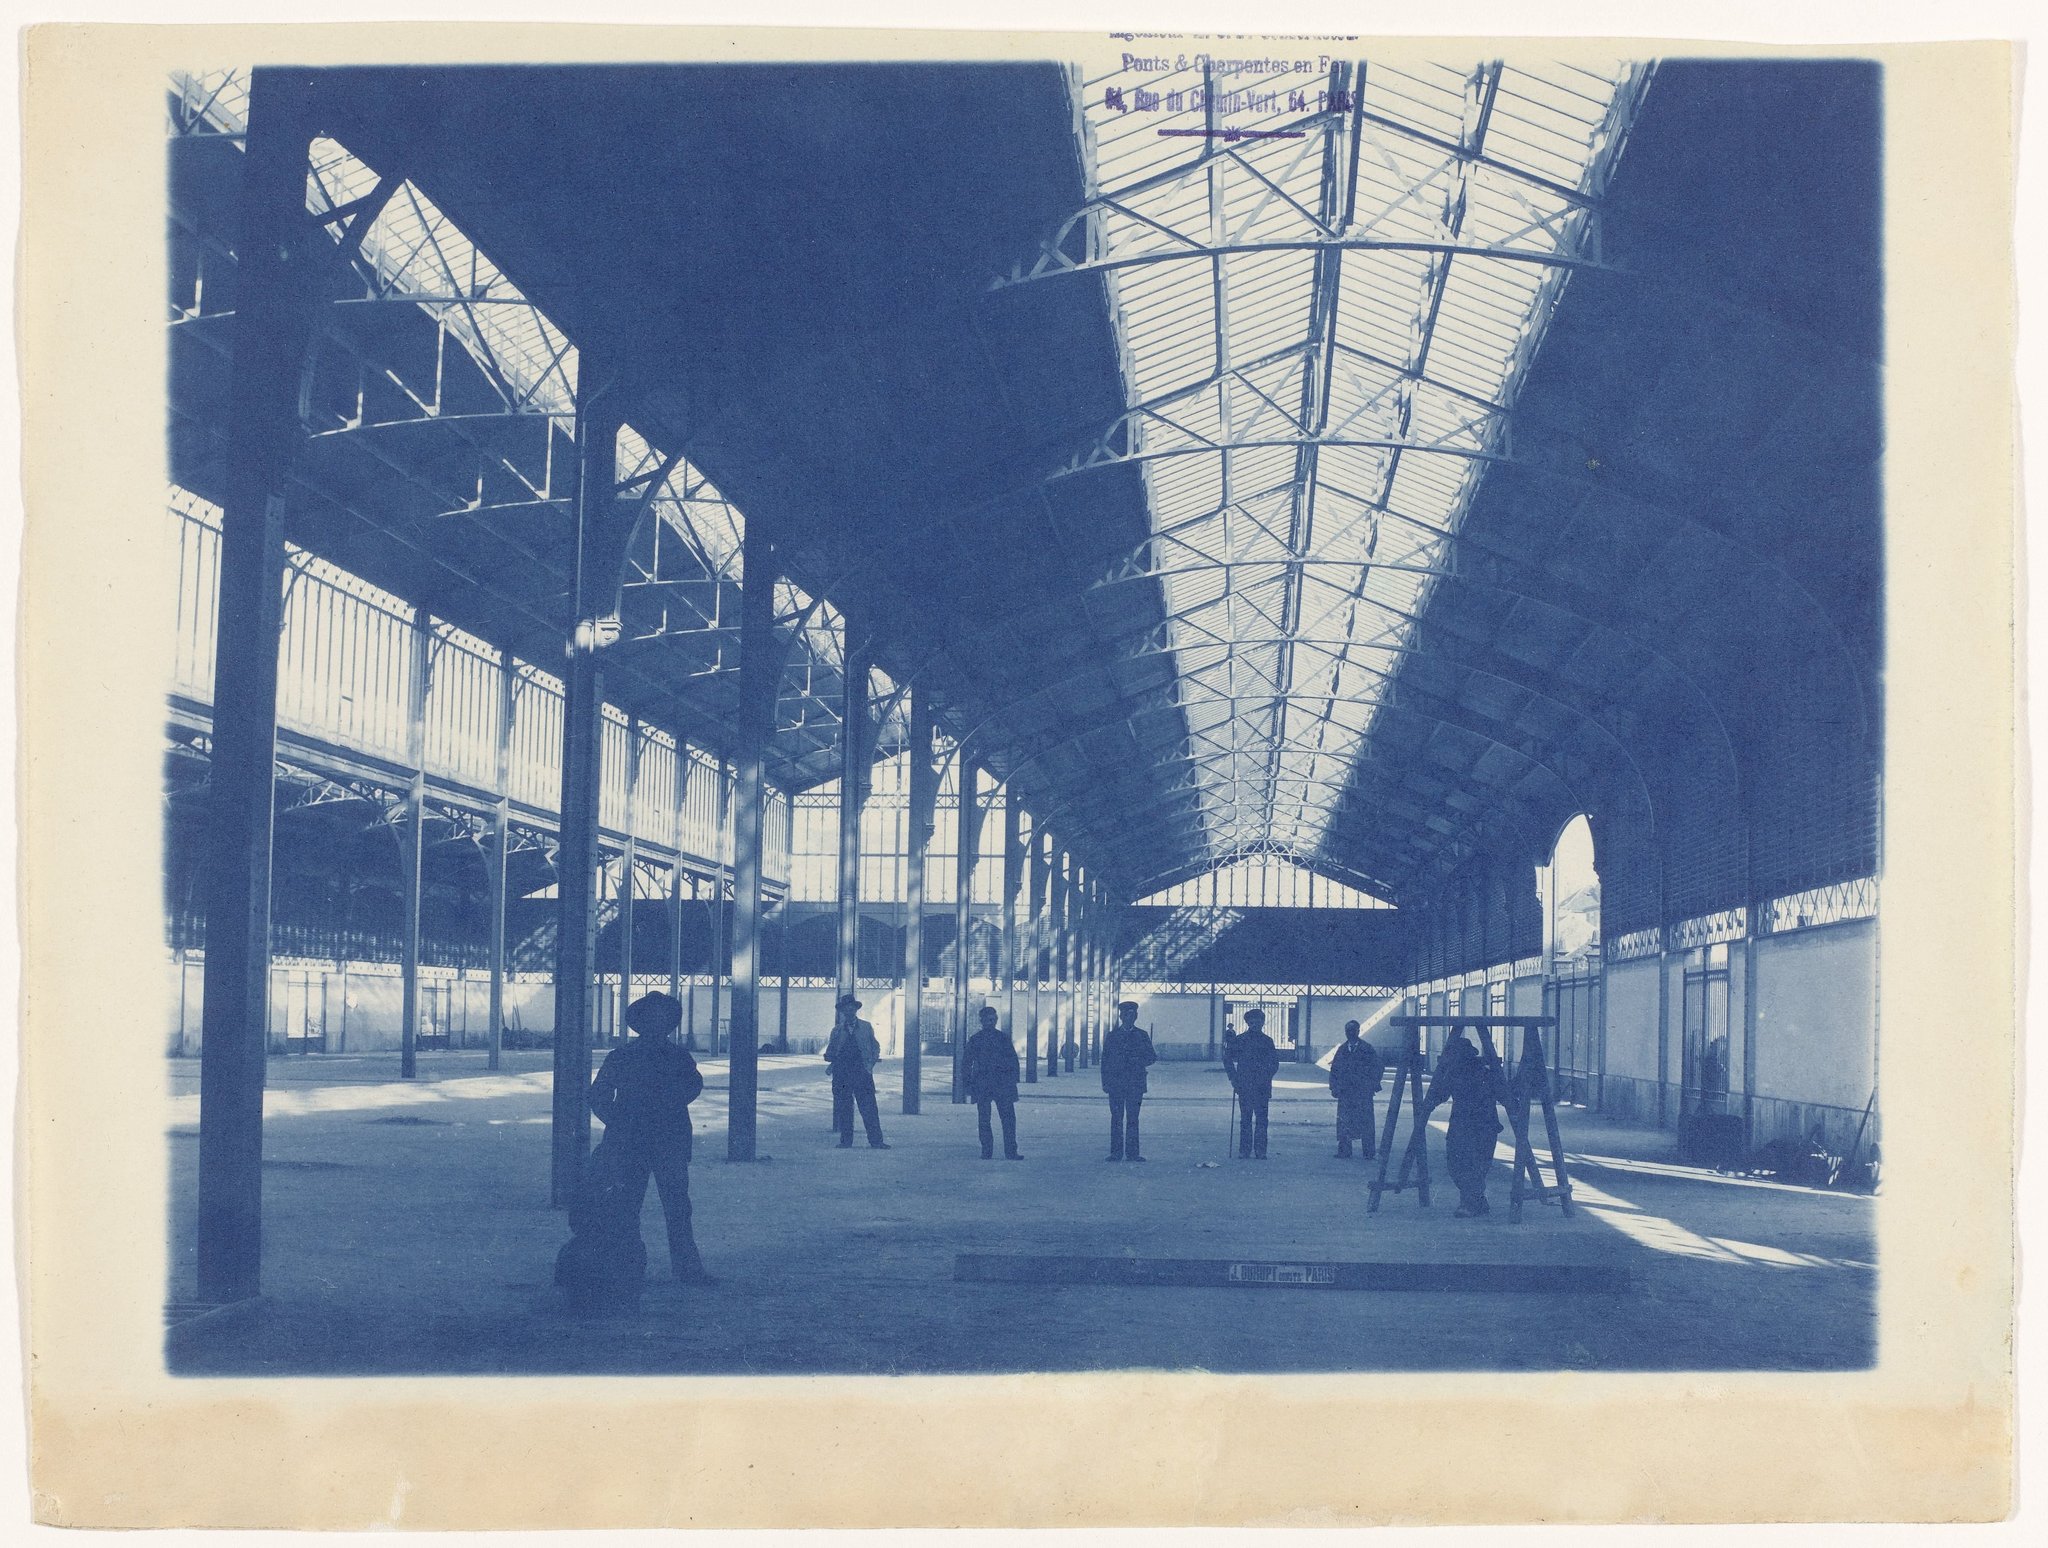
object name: photograph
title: The Construction of the Covered Market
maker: Anonymous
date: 1893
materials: photographic support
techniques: cyanotype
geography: paris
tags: building activities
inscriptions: inscription: ‘[...] Ponts & Charpentes en Fer/ 64, Rue du Chemin-Vert, 64. PARIS’, inscription: ‘J. DURUPT CONSTR PARIS’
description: In 1893 a new large covered market was erected in the Paris suburb of Saint-Denis. It was designed by the engineer Durupt, whose name is visible on the girder on the ground. The photograph probably only served as an architectural record: otherwise it would not have been stamped so flatly on the front with the words ponts & charpentes en fer (bridges and iron constructions).